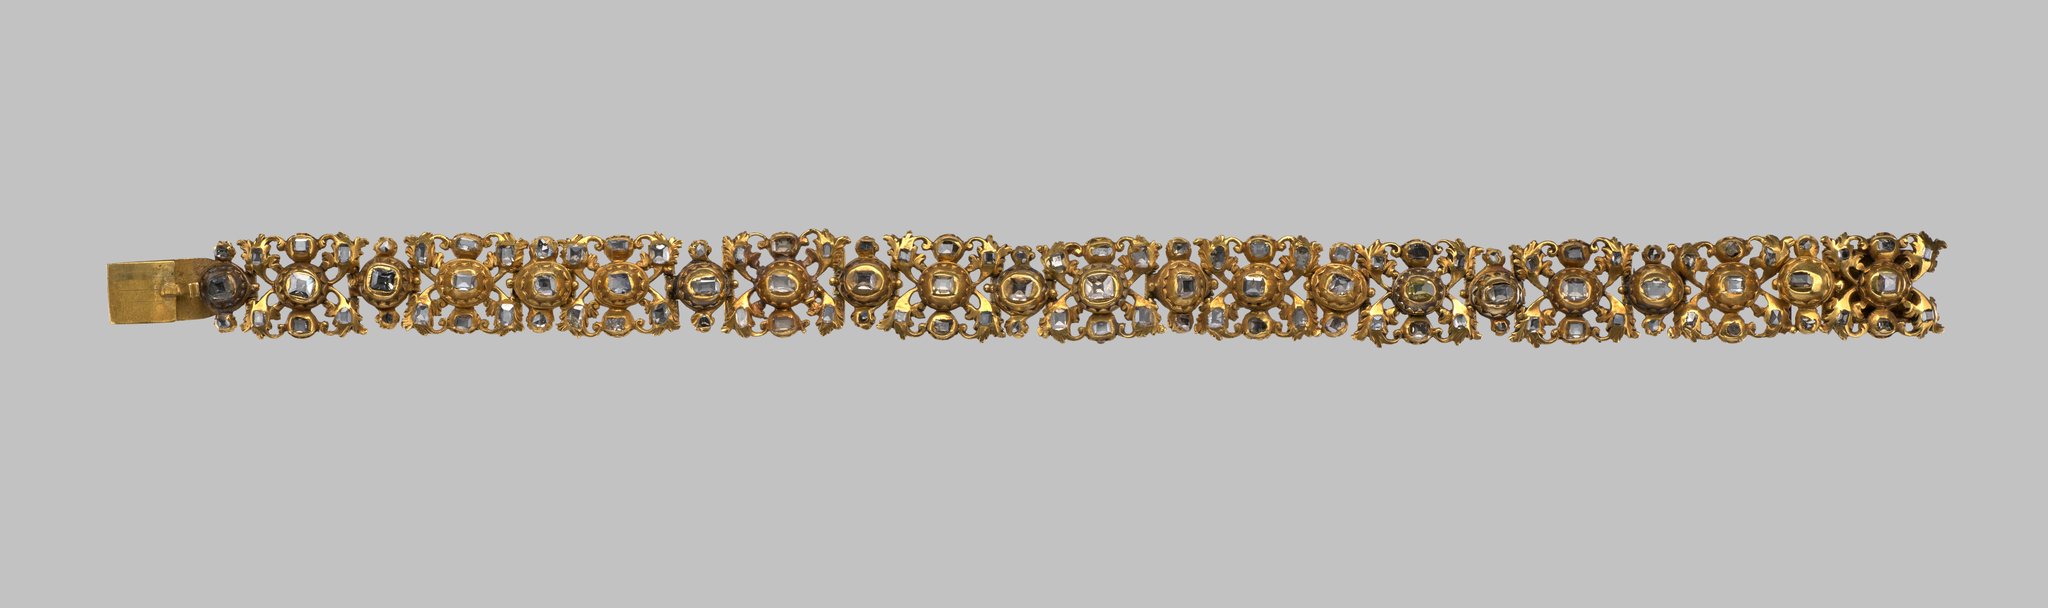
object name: bracelet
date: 1601-1700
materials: diamond, gold